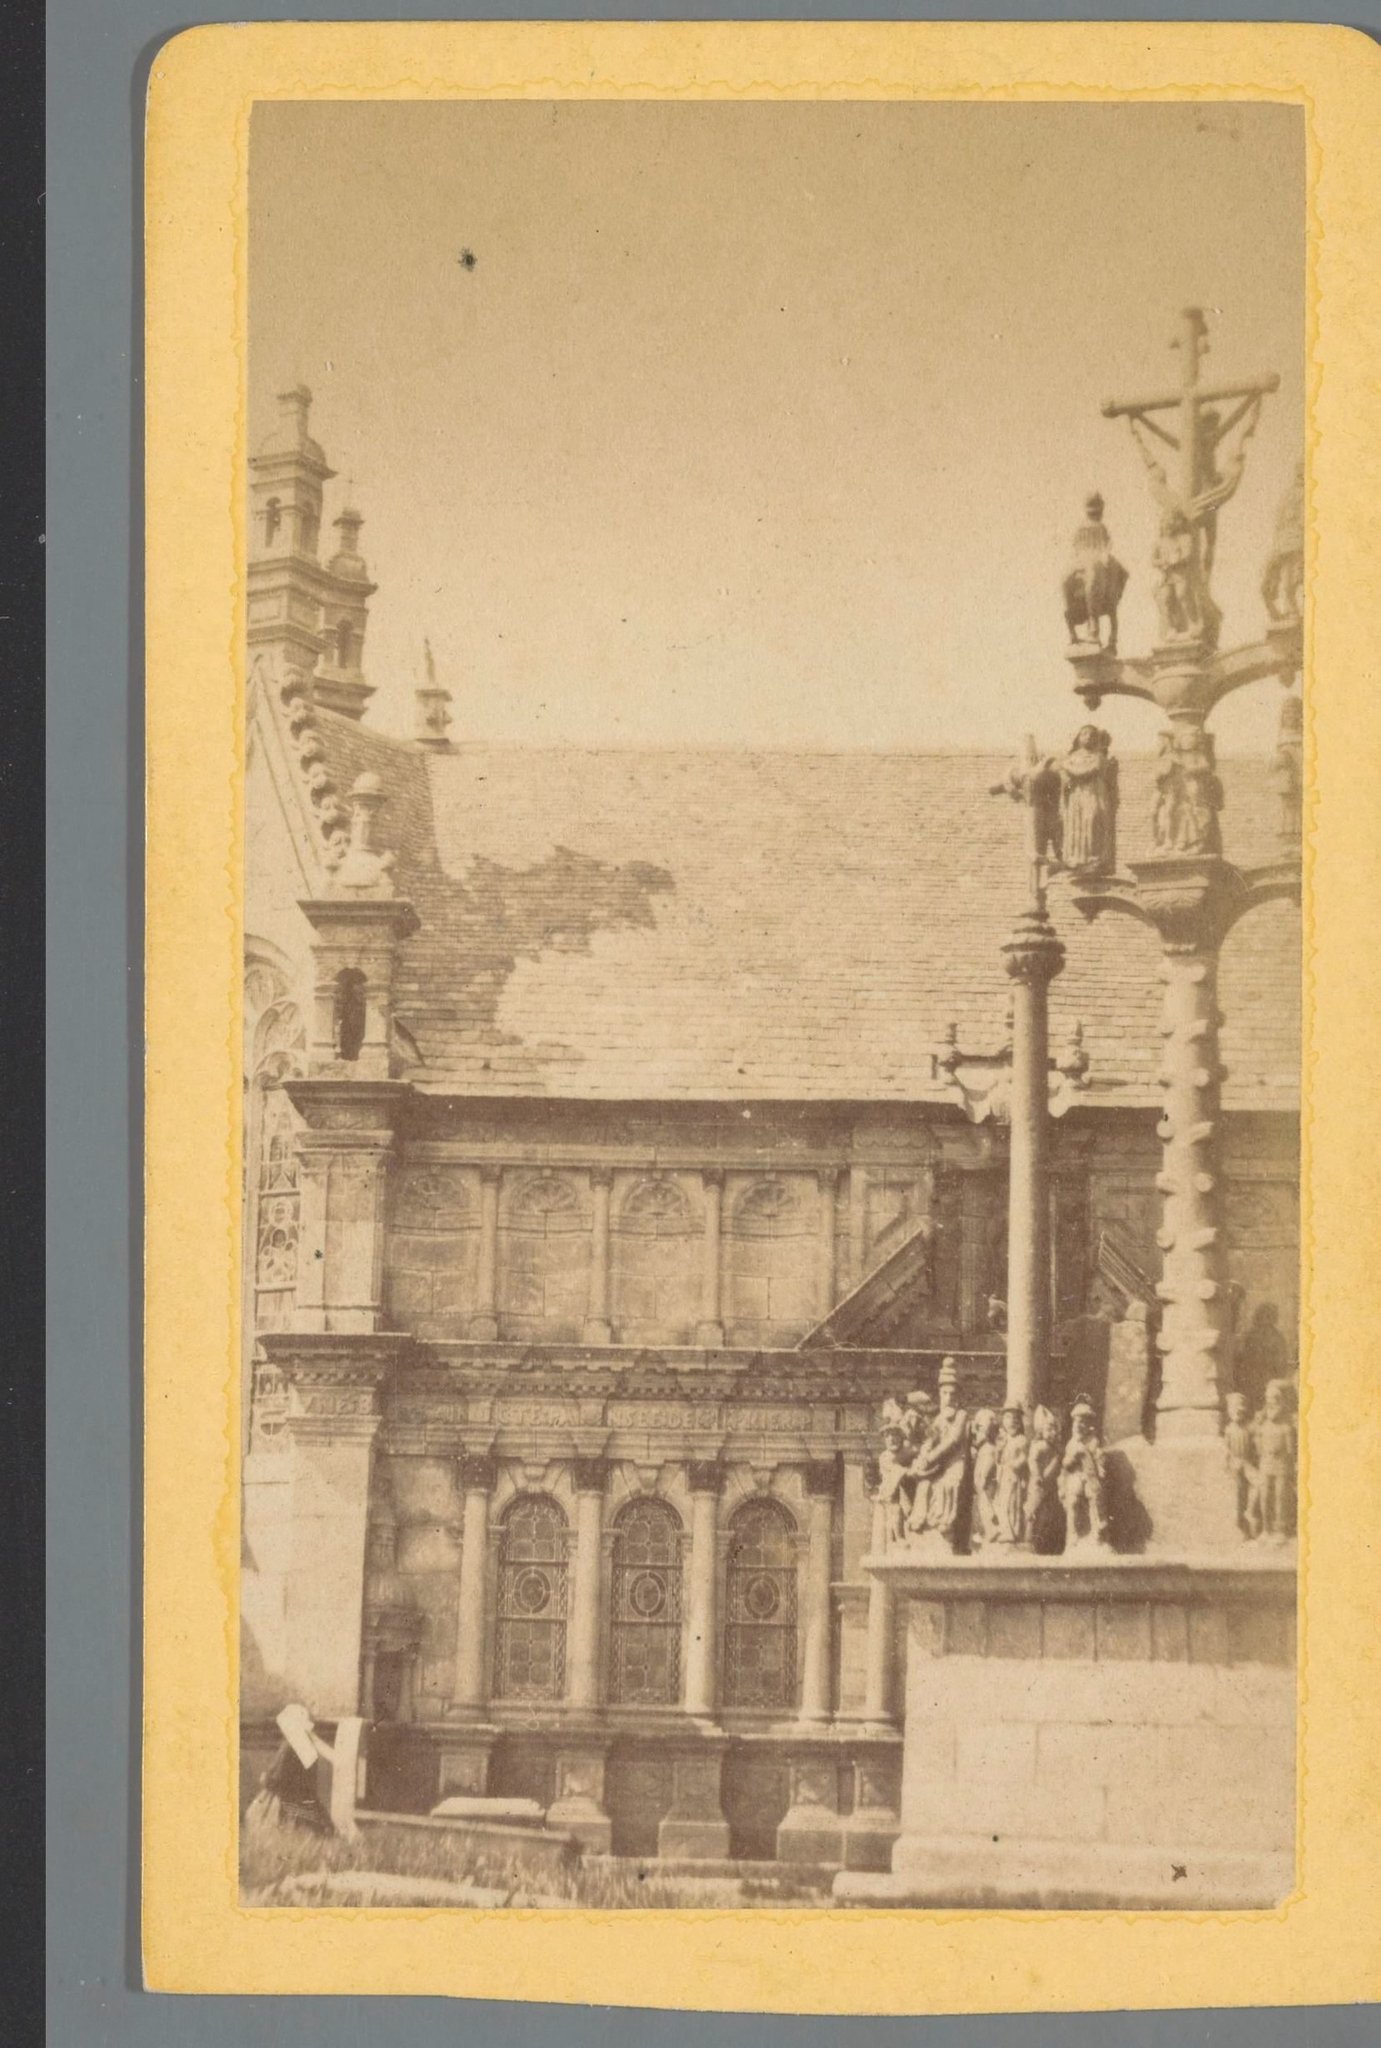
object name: carte de visite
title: Voyage en Bretagne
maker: Anonymous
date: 1865-1880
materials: cardboard, paper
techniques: albumen print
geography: france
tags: guimiliau, calvaire, bretagne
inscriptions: title: ‘VOYAGE EN BRETAGNE’, annotation: ‘[onleesbaar] / 8 juillet’